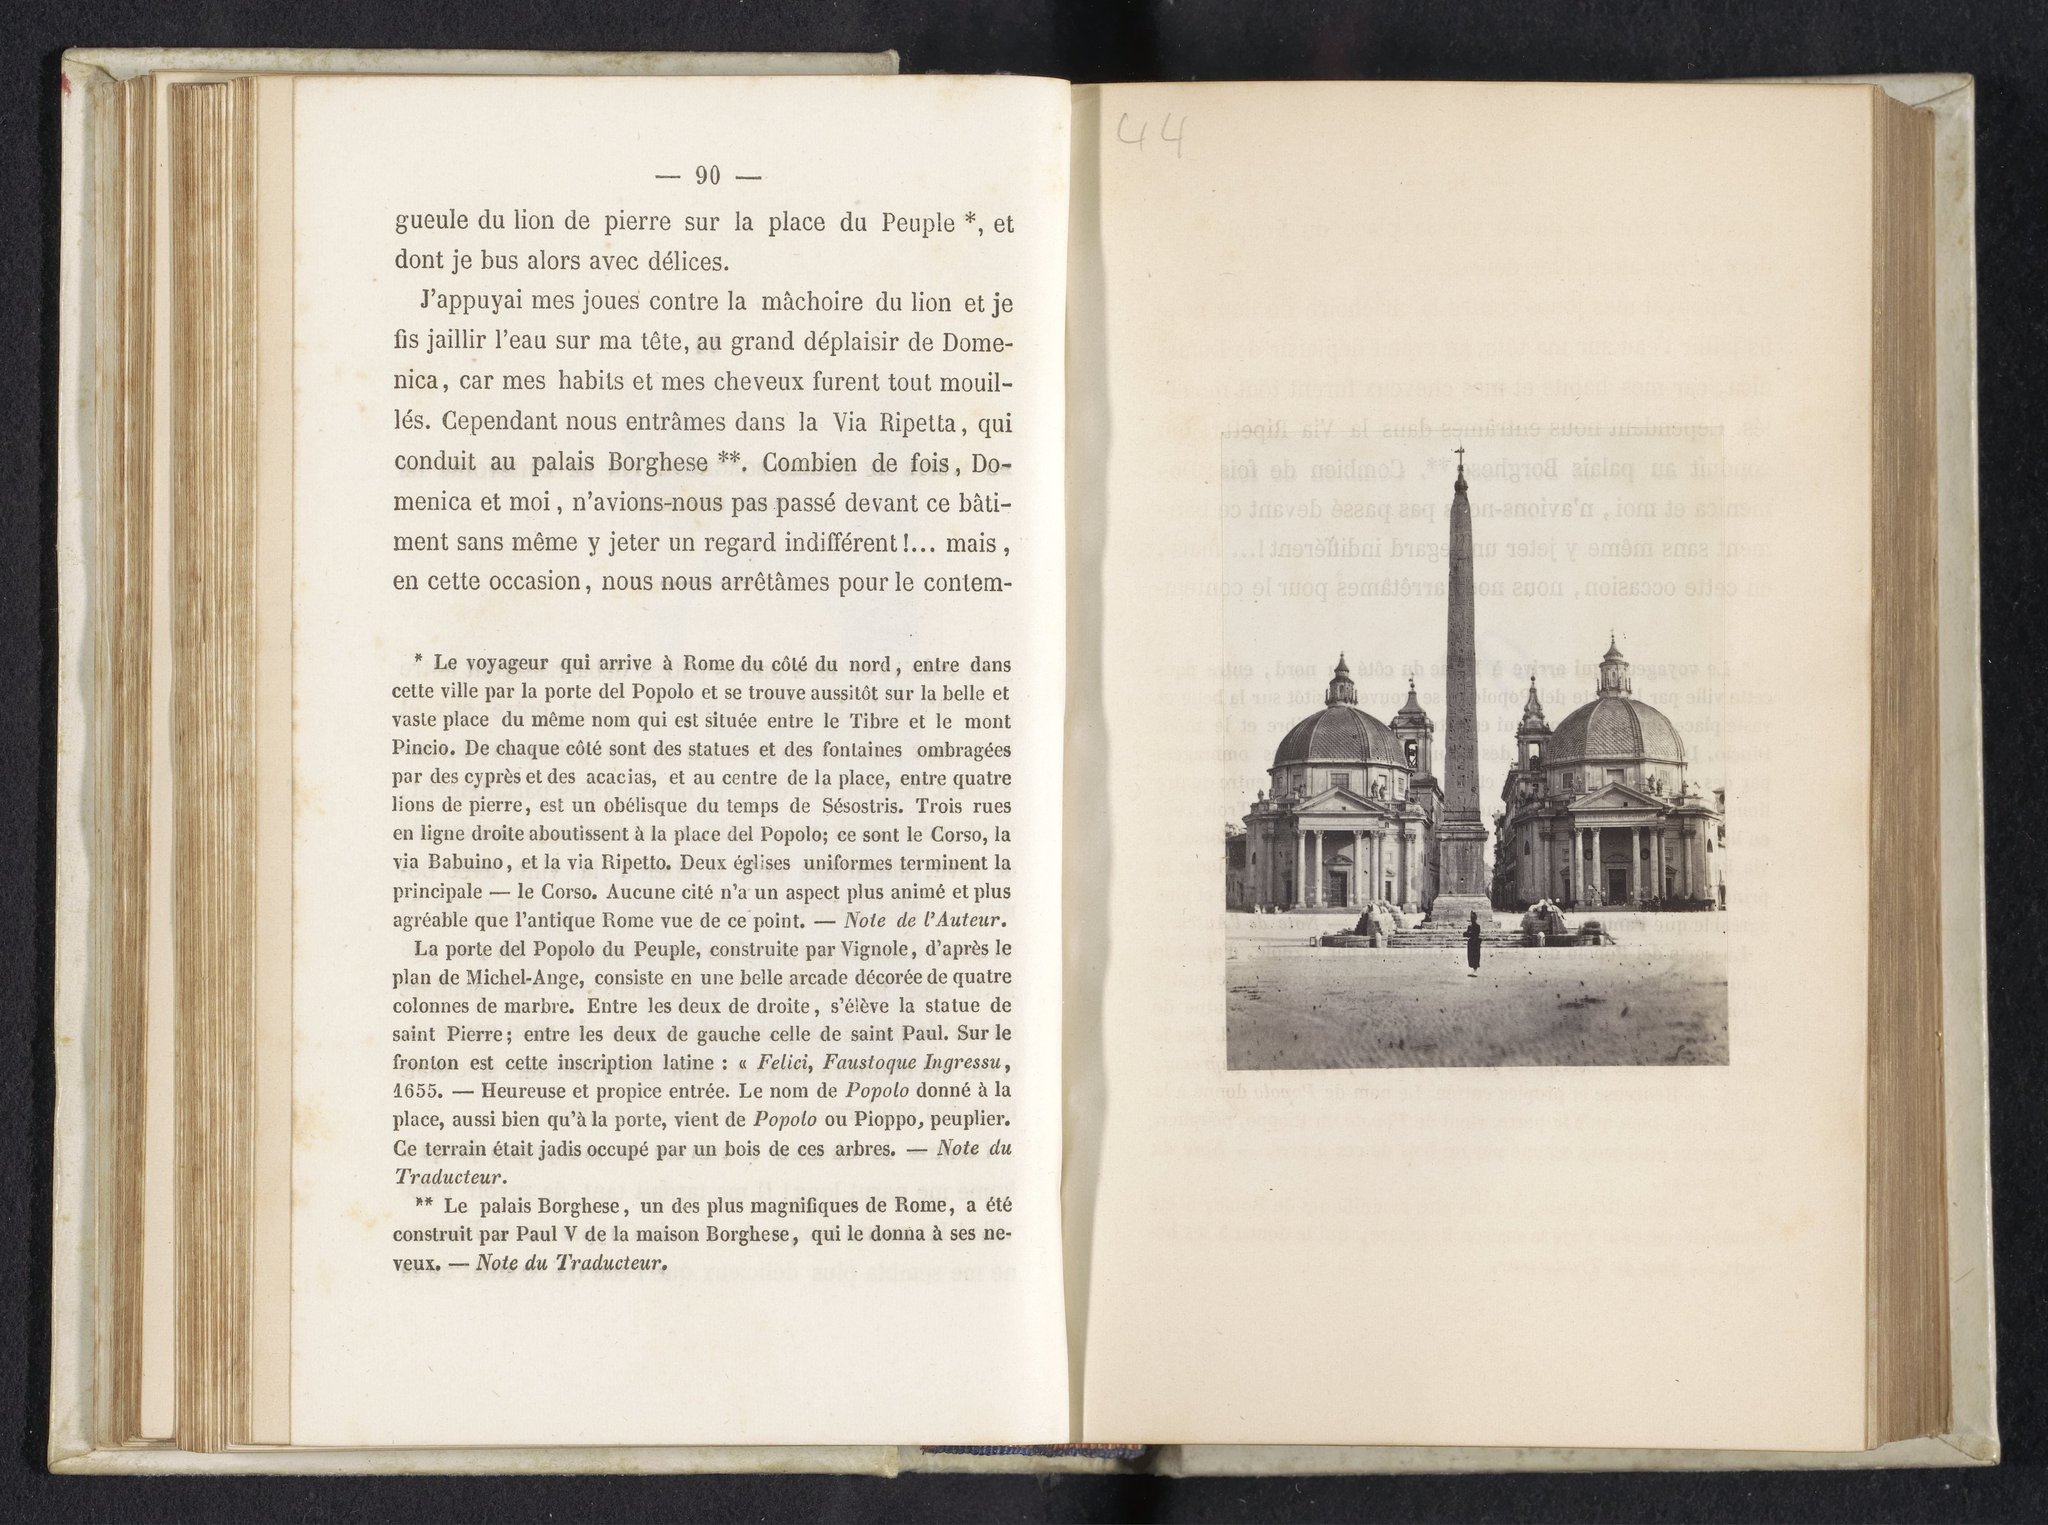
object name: photograph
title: Flaminische Obelisk op het Piazza del Popolo te Rome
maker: Anonymous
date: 1850-1860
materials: photographic support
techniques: albumen print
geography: piazza del popolo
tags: square, place, circus, etc., obelisk, needle